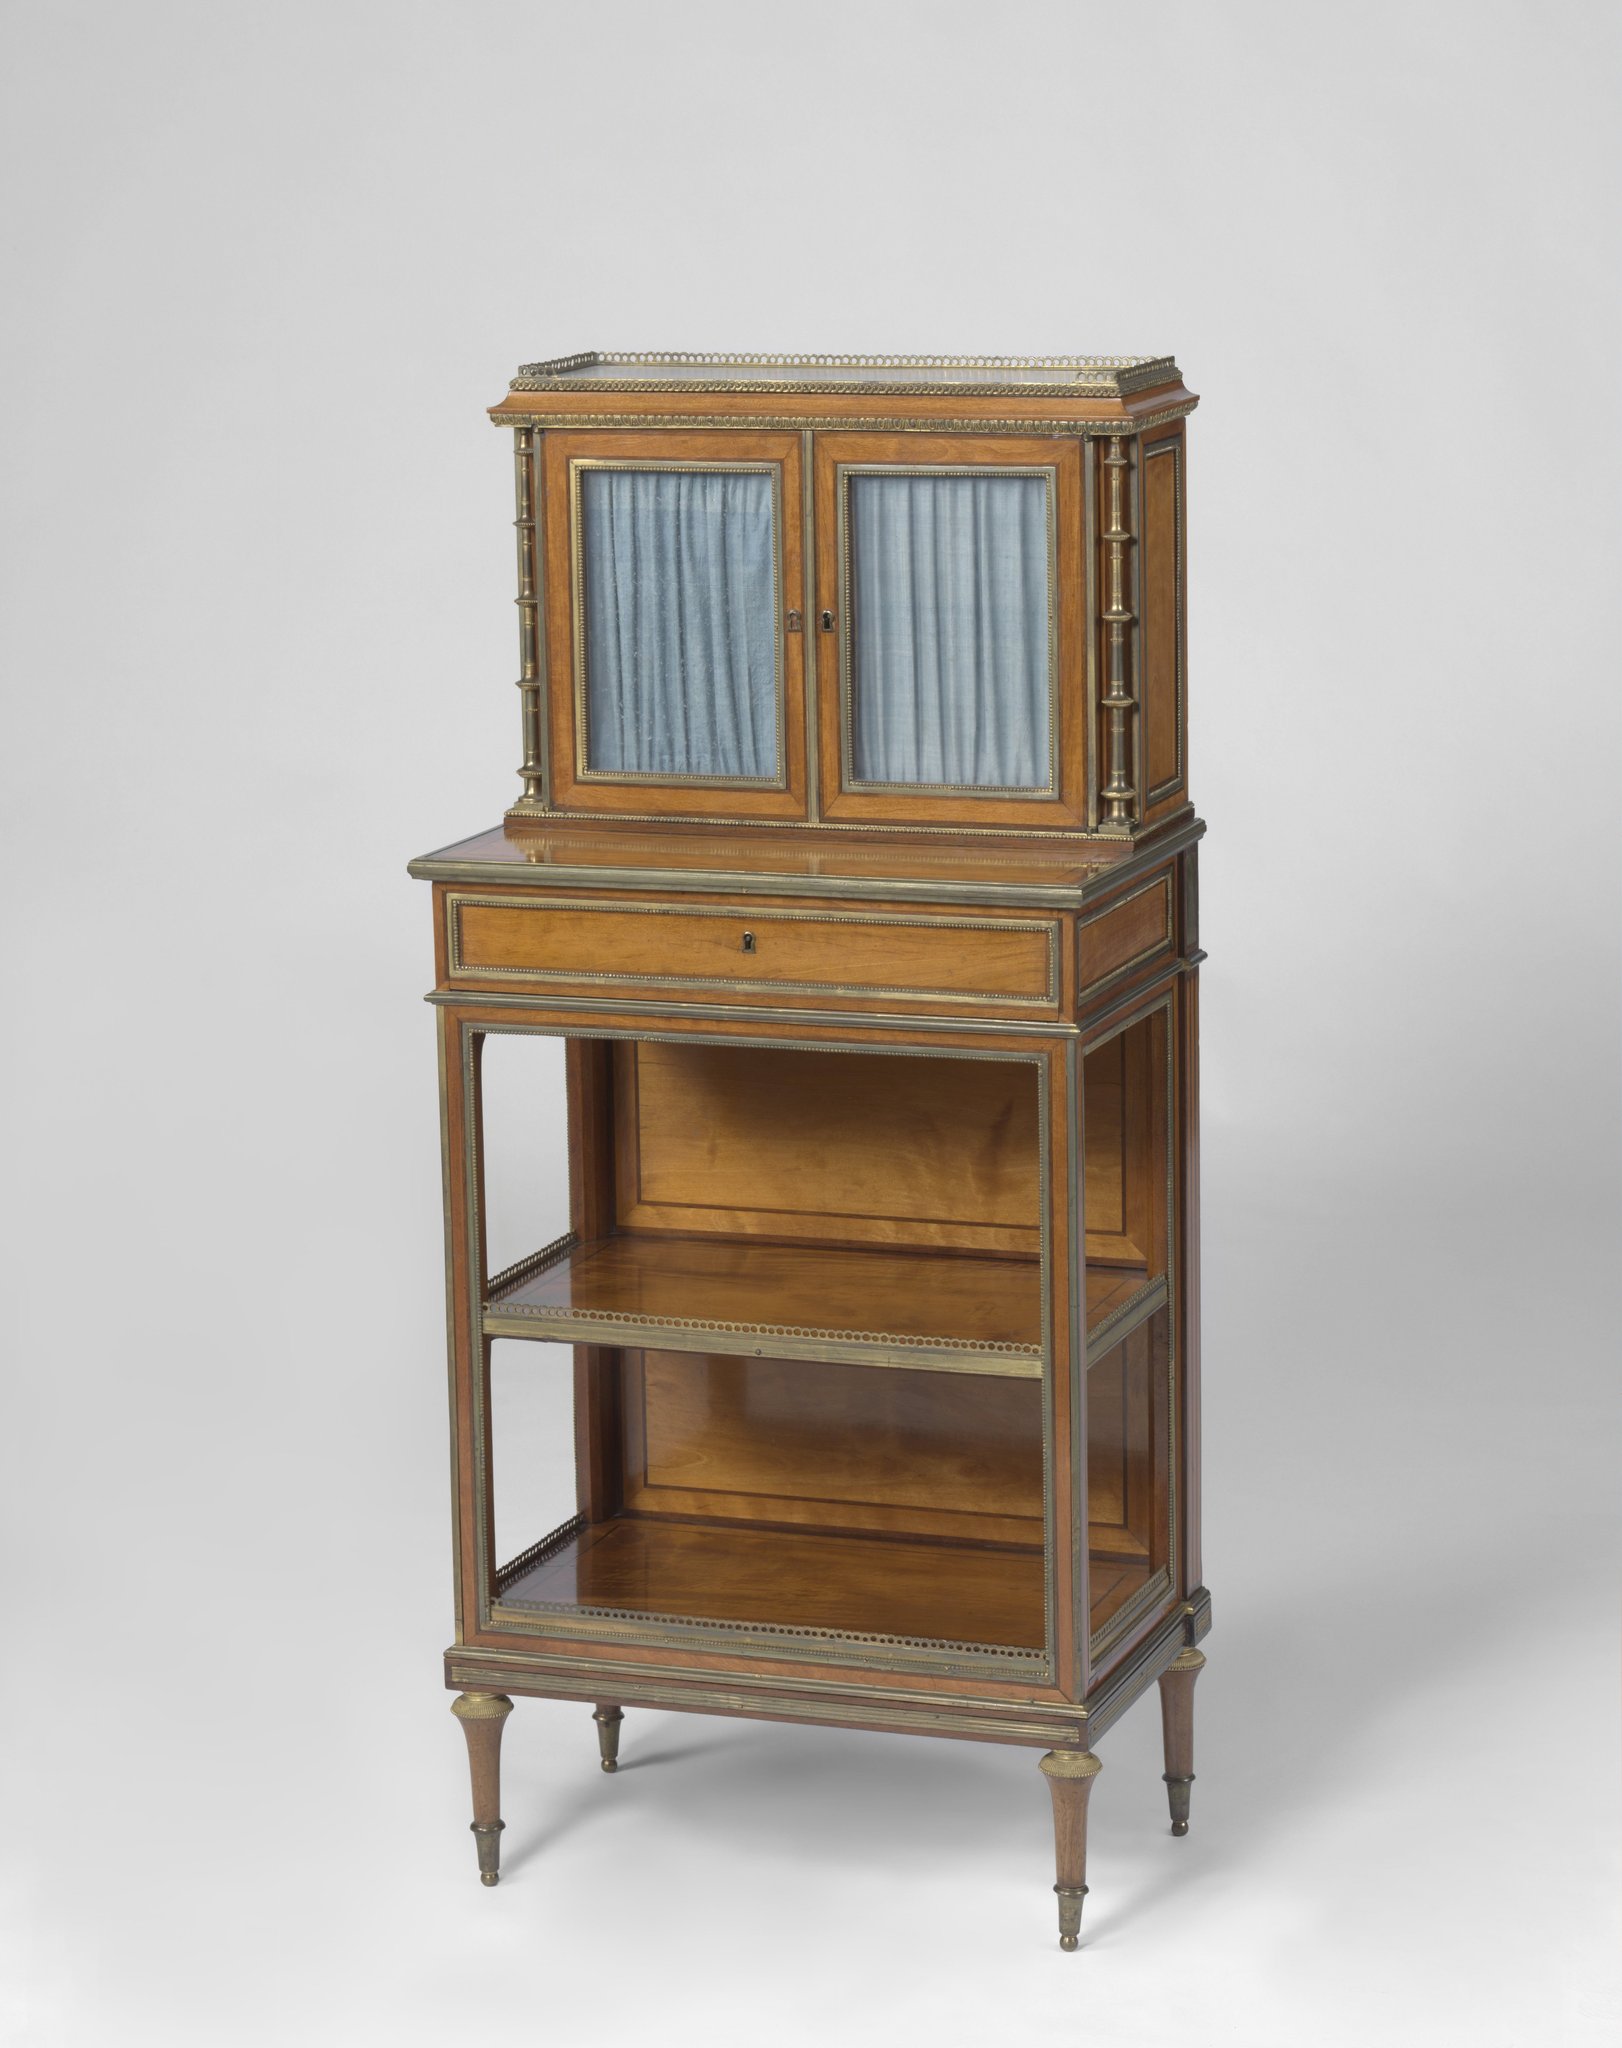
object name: furniture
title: Bonheur du jour met onder- en middenblad en met terugspringend opzetstuk met twee deurtjes. Opengewerkte kroonlijst. Blad van wit marmer.Belijmd met verschillende houtsoorten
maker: adam weisweiler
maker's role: furniture worker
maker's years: 1744-1820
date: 1785-1790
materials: bronze, copper, glass, wood, marble, silk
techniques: gilding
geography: paris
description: Bonheur du jour. Oak, veneered with satinwood and purplewood. Paris, c. 1790.